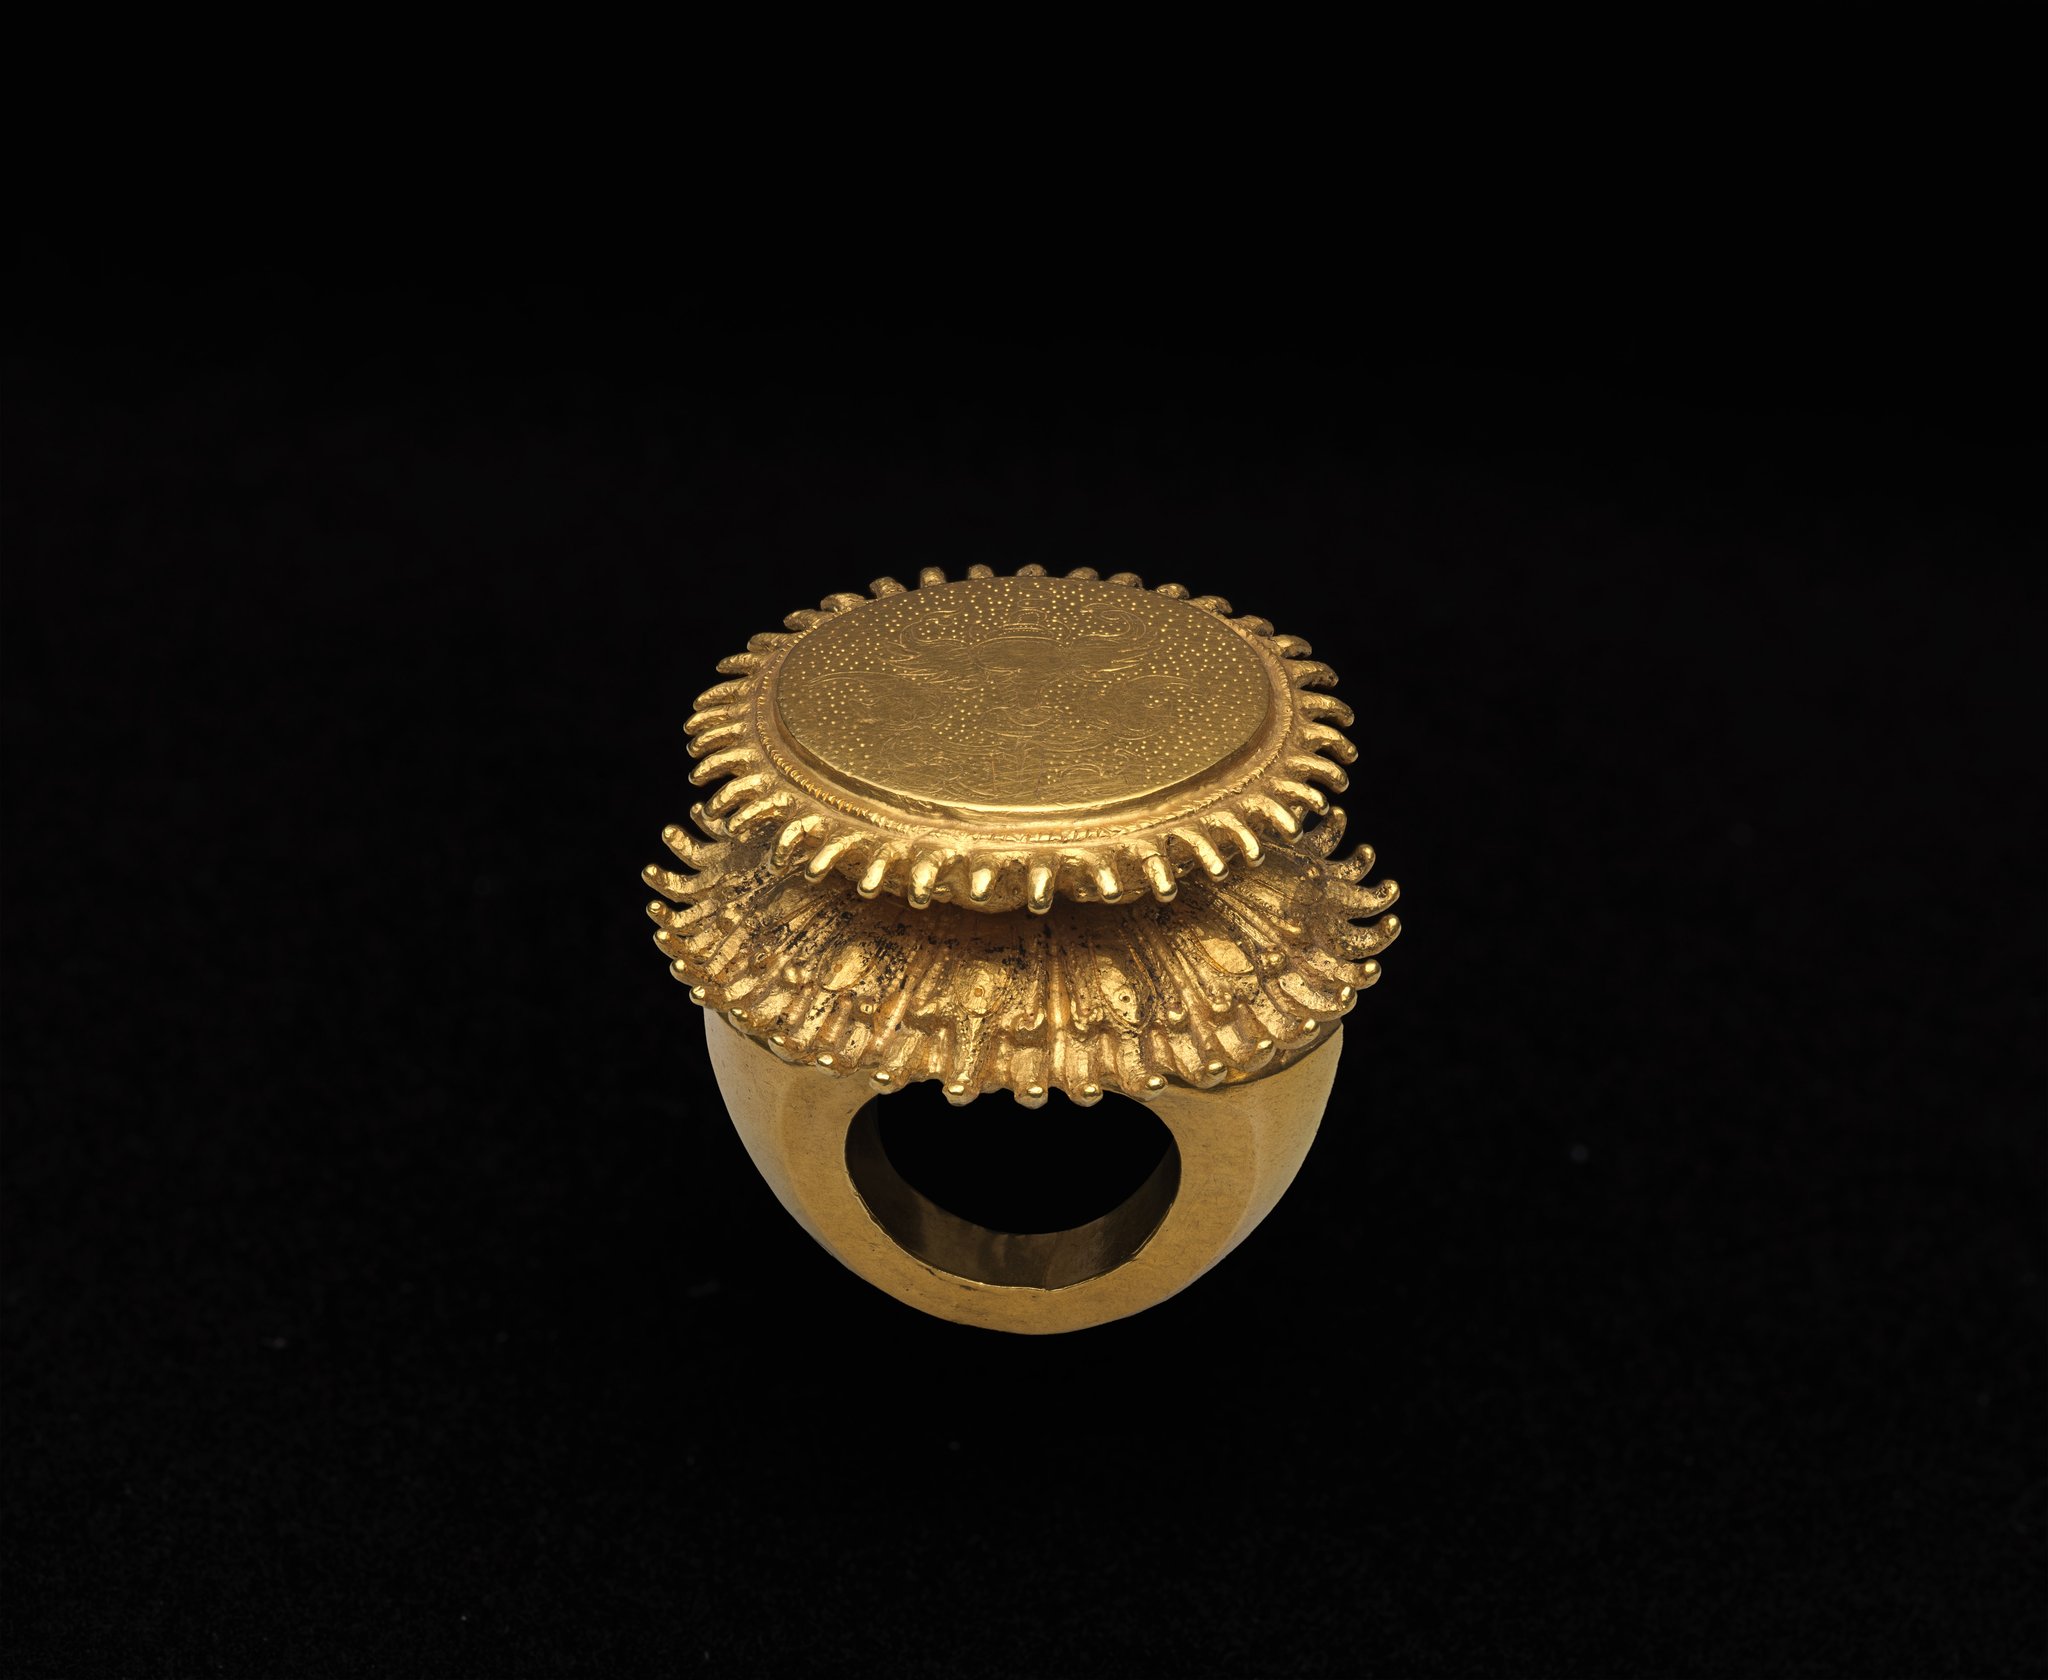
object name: ring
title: Double Lotus Shaped Ring with Incised Conch Motif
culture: indonesian, javanese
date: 701-933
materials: gold